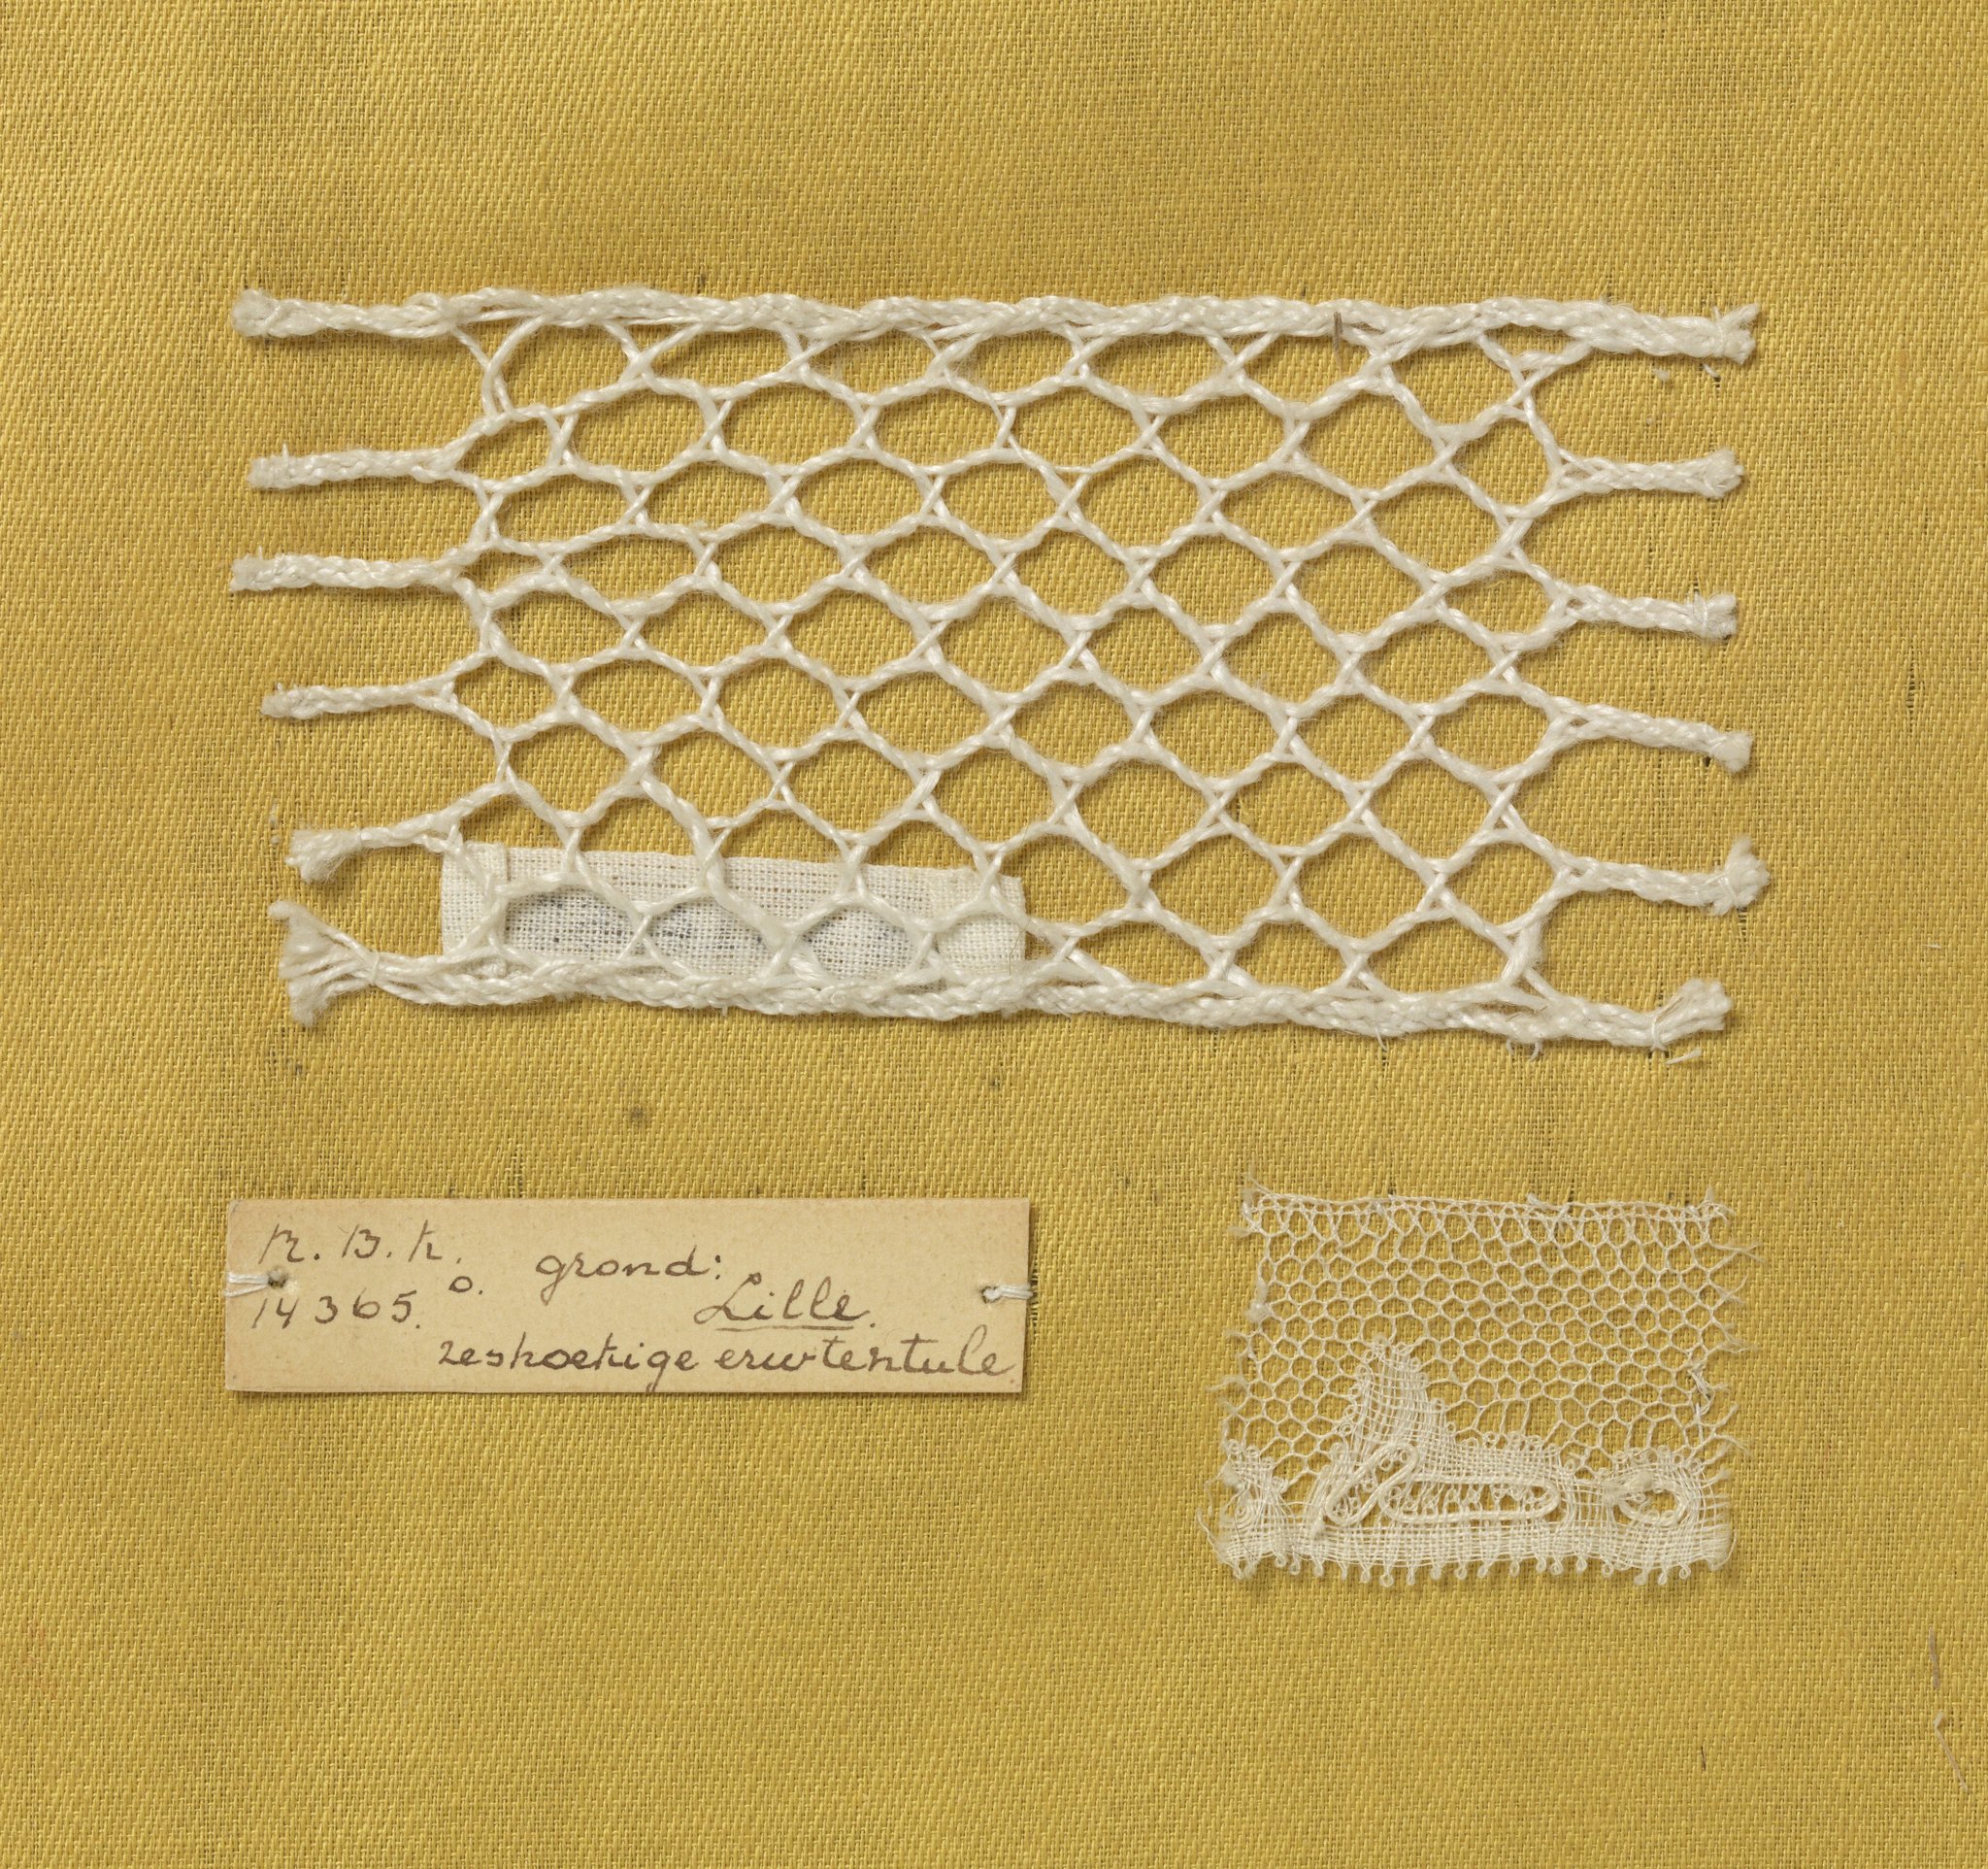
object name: sample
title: Staal kloskant met grove draad als voorbeeld van een tulegrond (traliegrond)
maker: Anonymous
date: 1900-1930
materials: cotton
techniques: lace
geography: amsterdam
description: Staal naturelkleurige kloskant met grove draad als voorbeeld van een tulegrond met daarbij een fragment kant waarin deze techniek is toegepast. De datering betreft het staal.